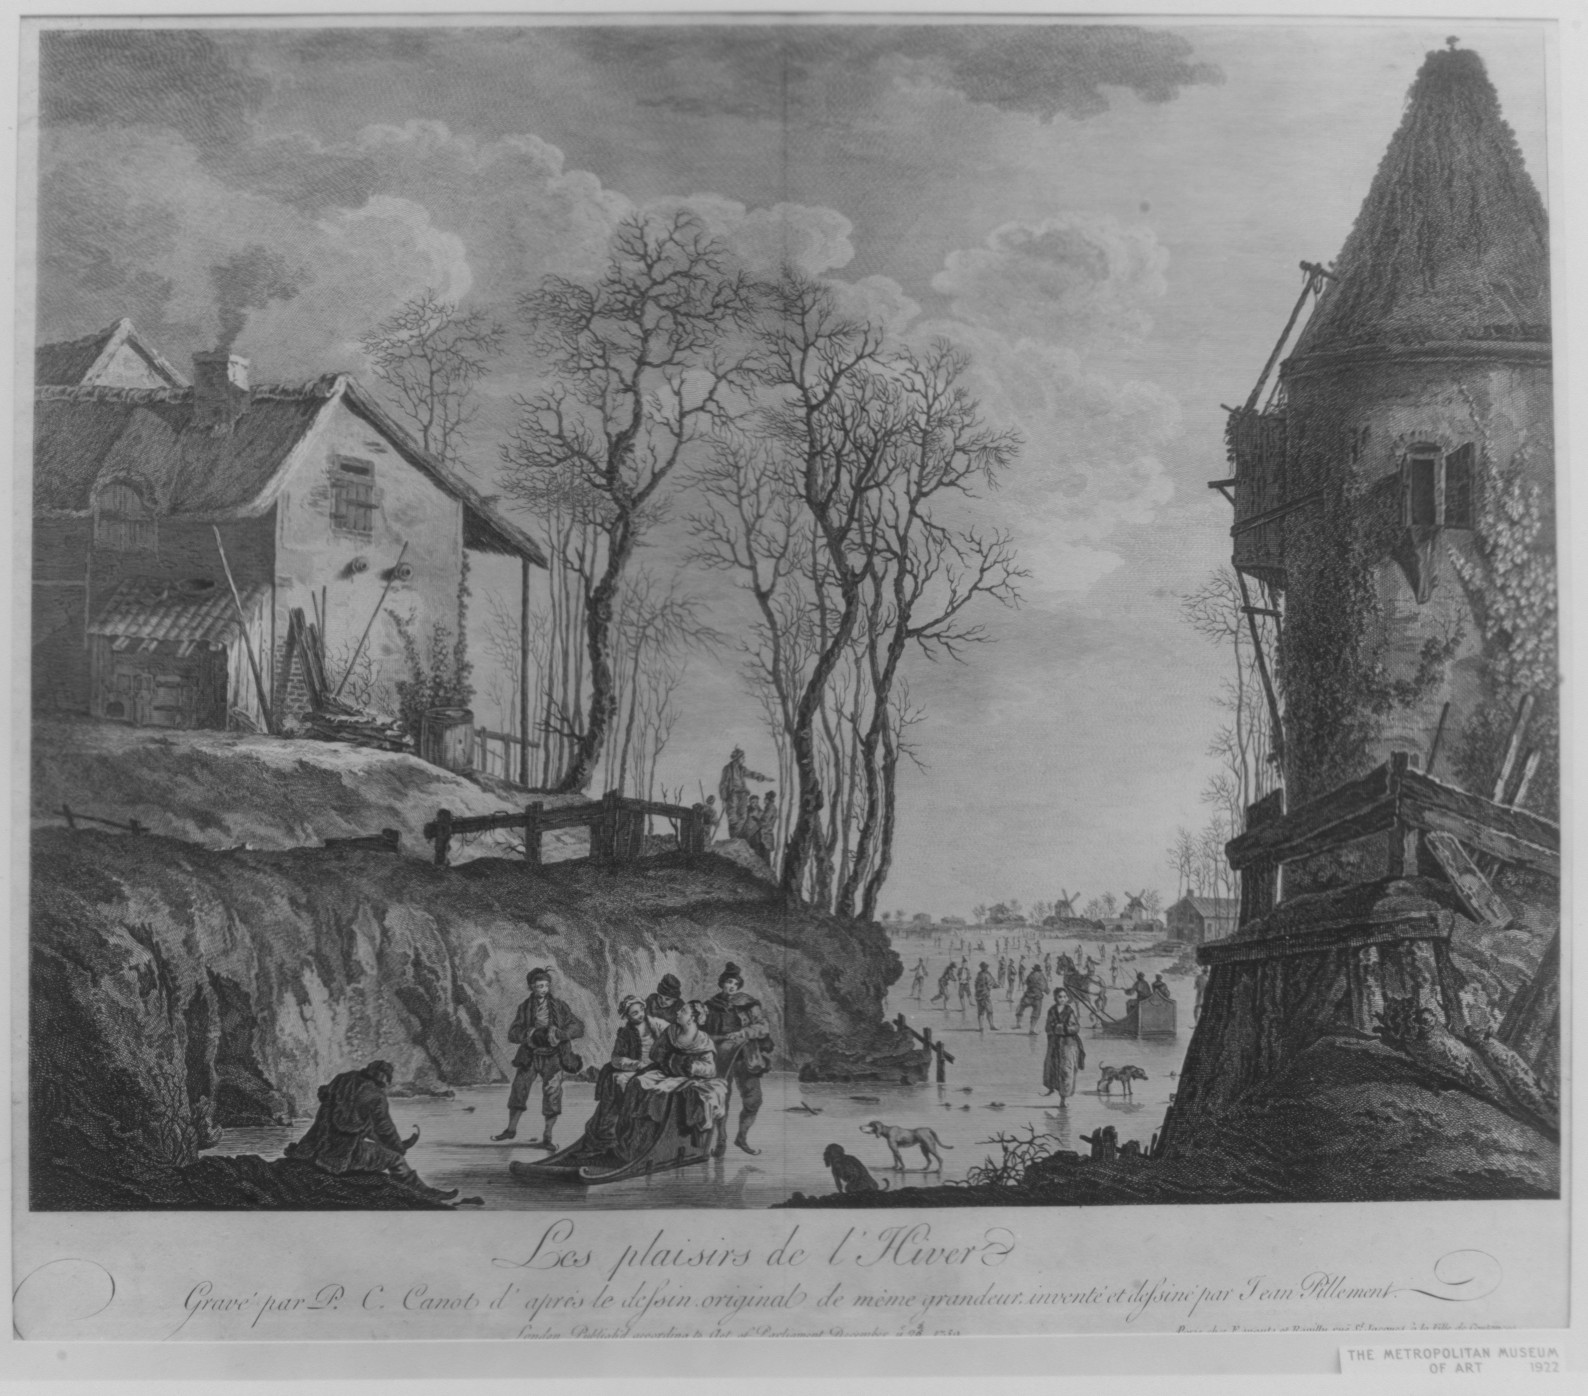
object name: print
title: The Delights of Winter (Les Plaisirs de l'Hiver)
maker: pierre charles canot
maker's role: engraver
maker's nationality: french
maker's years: 1710-1777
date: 1759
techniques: etching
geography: france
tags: houses,men,women,trees,winter